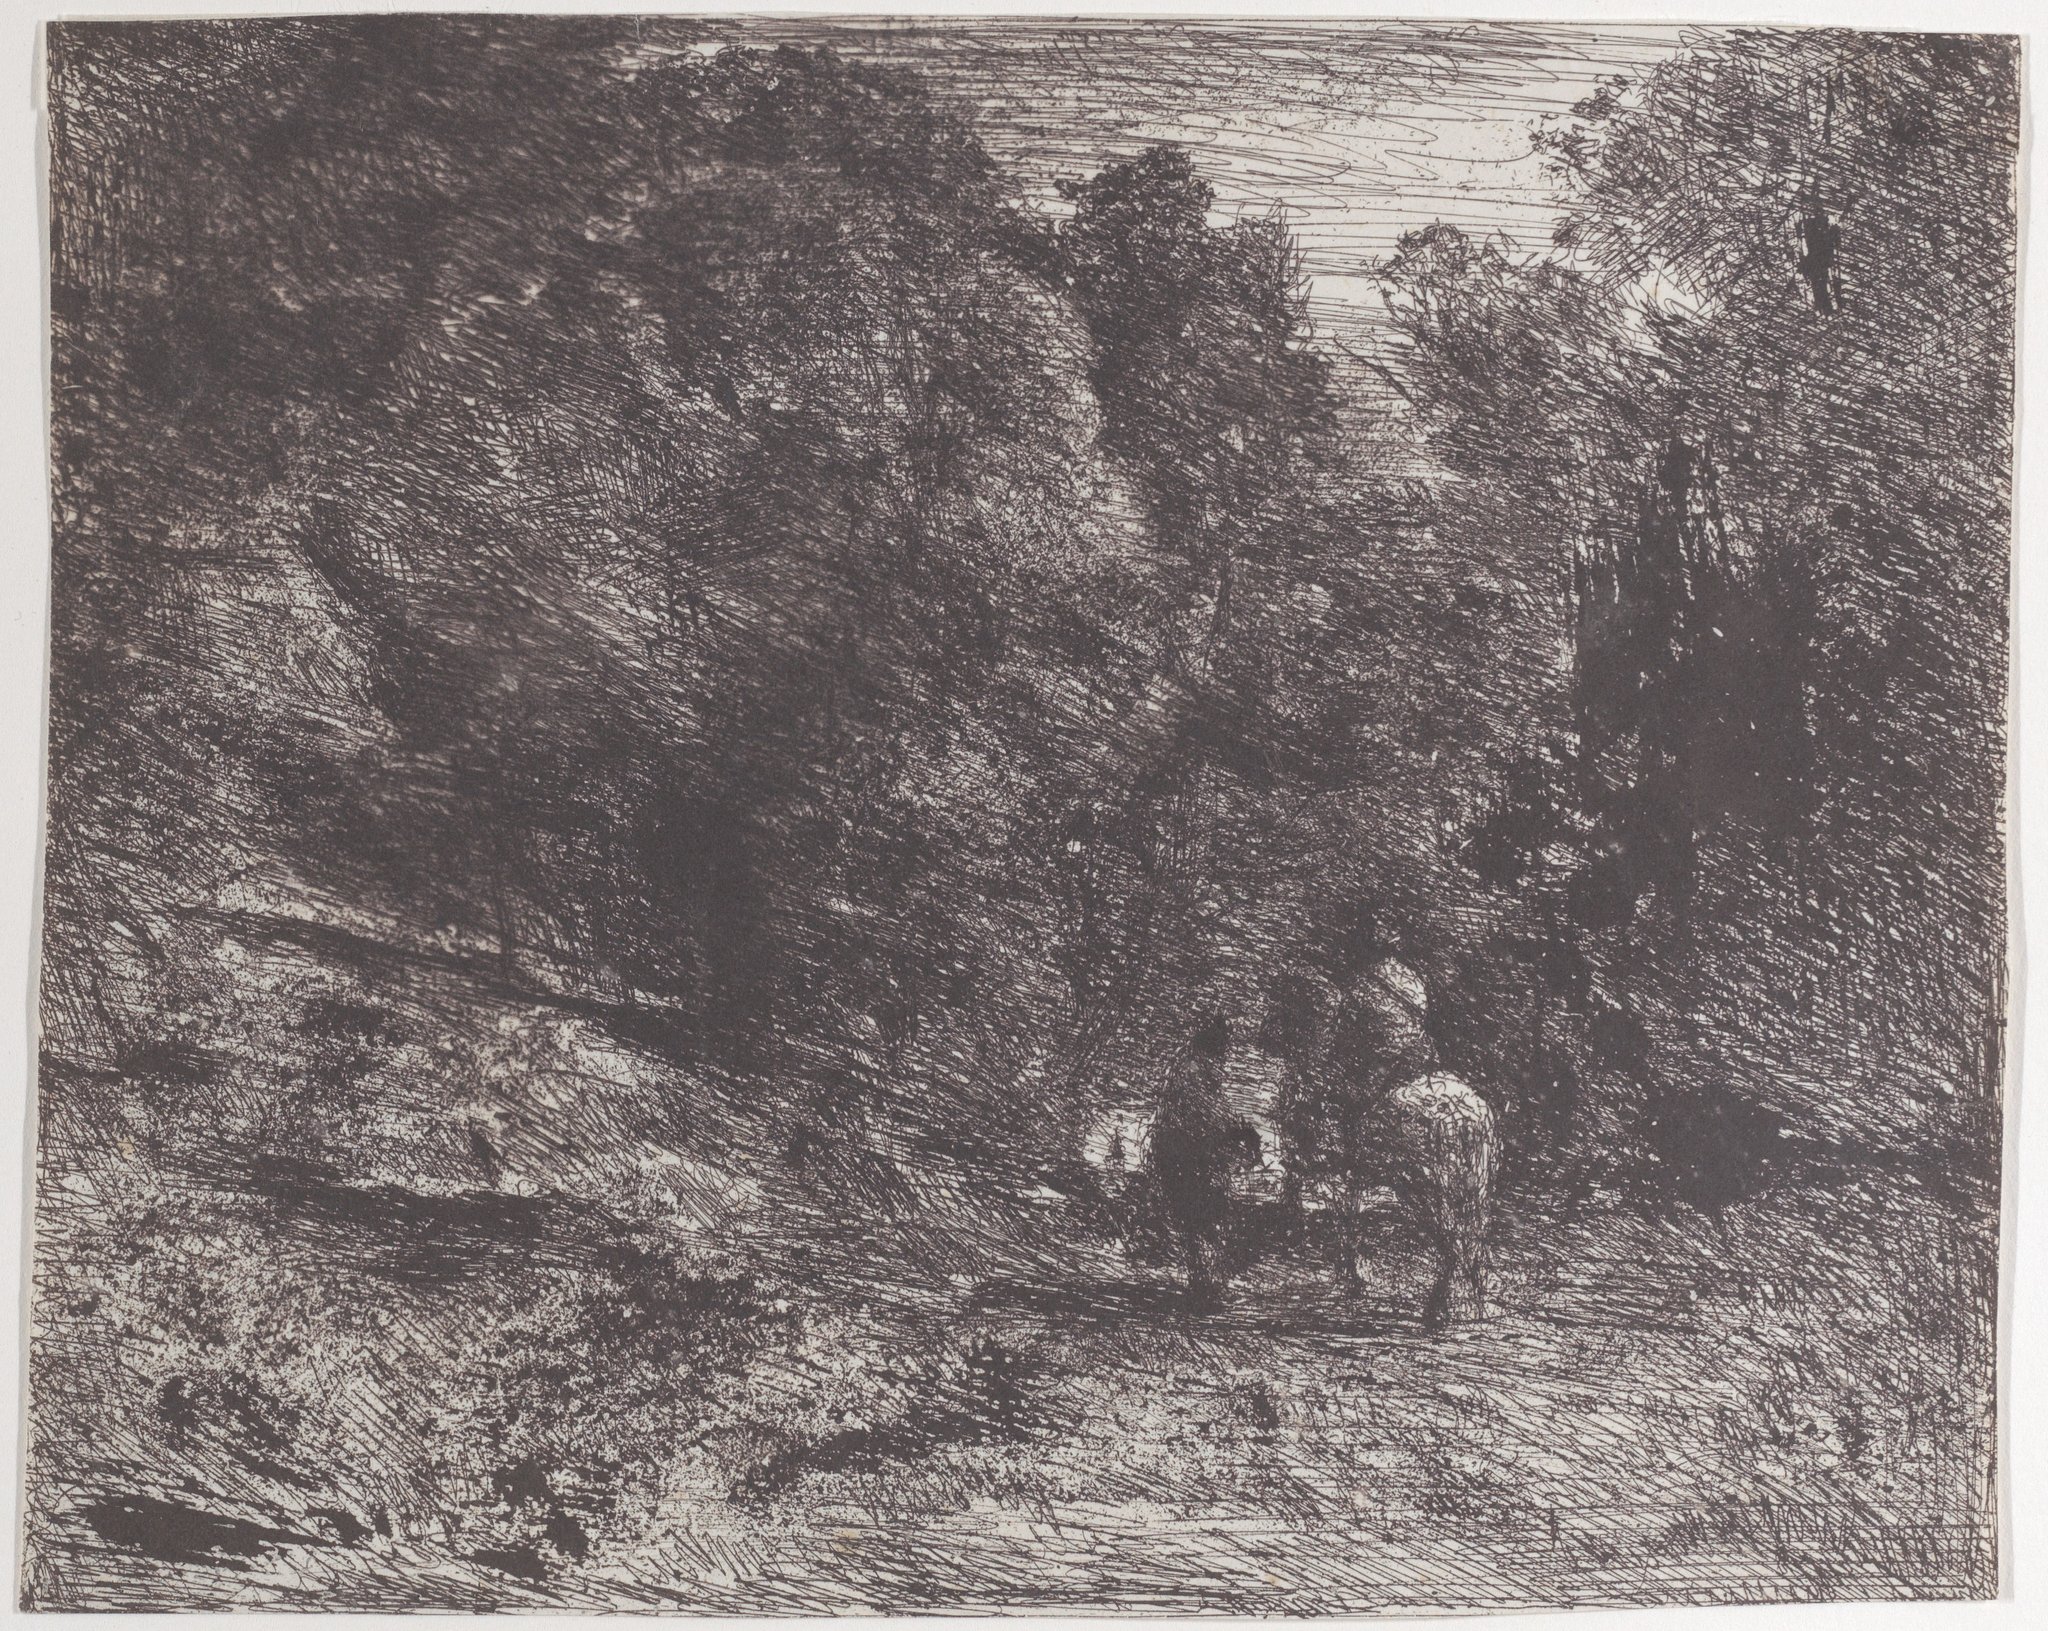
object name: print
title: Two Travelers in a Forest (Le Cavalier en forêt et le piéton)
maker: jean-baptiste-camille corot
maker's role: artist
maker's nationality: french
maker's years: 1796-1875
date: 1854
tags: horses,forests,landscapes